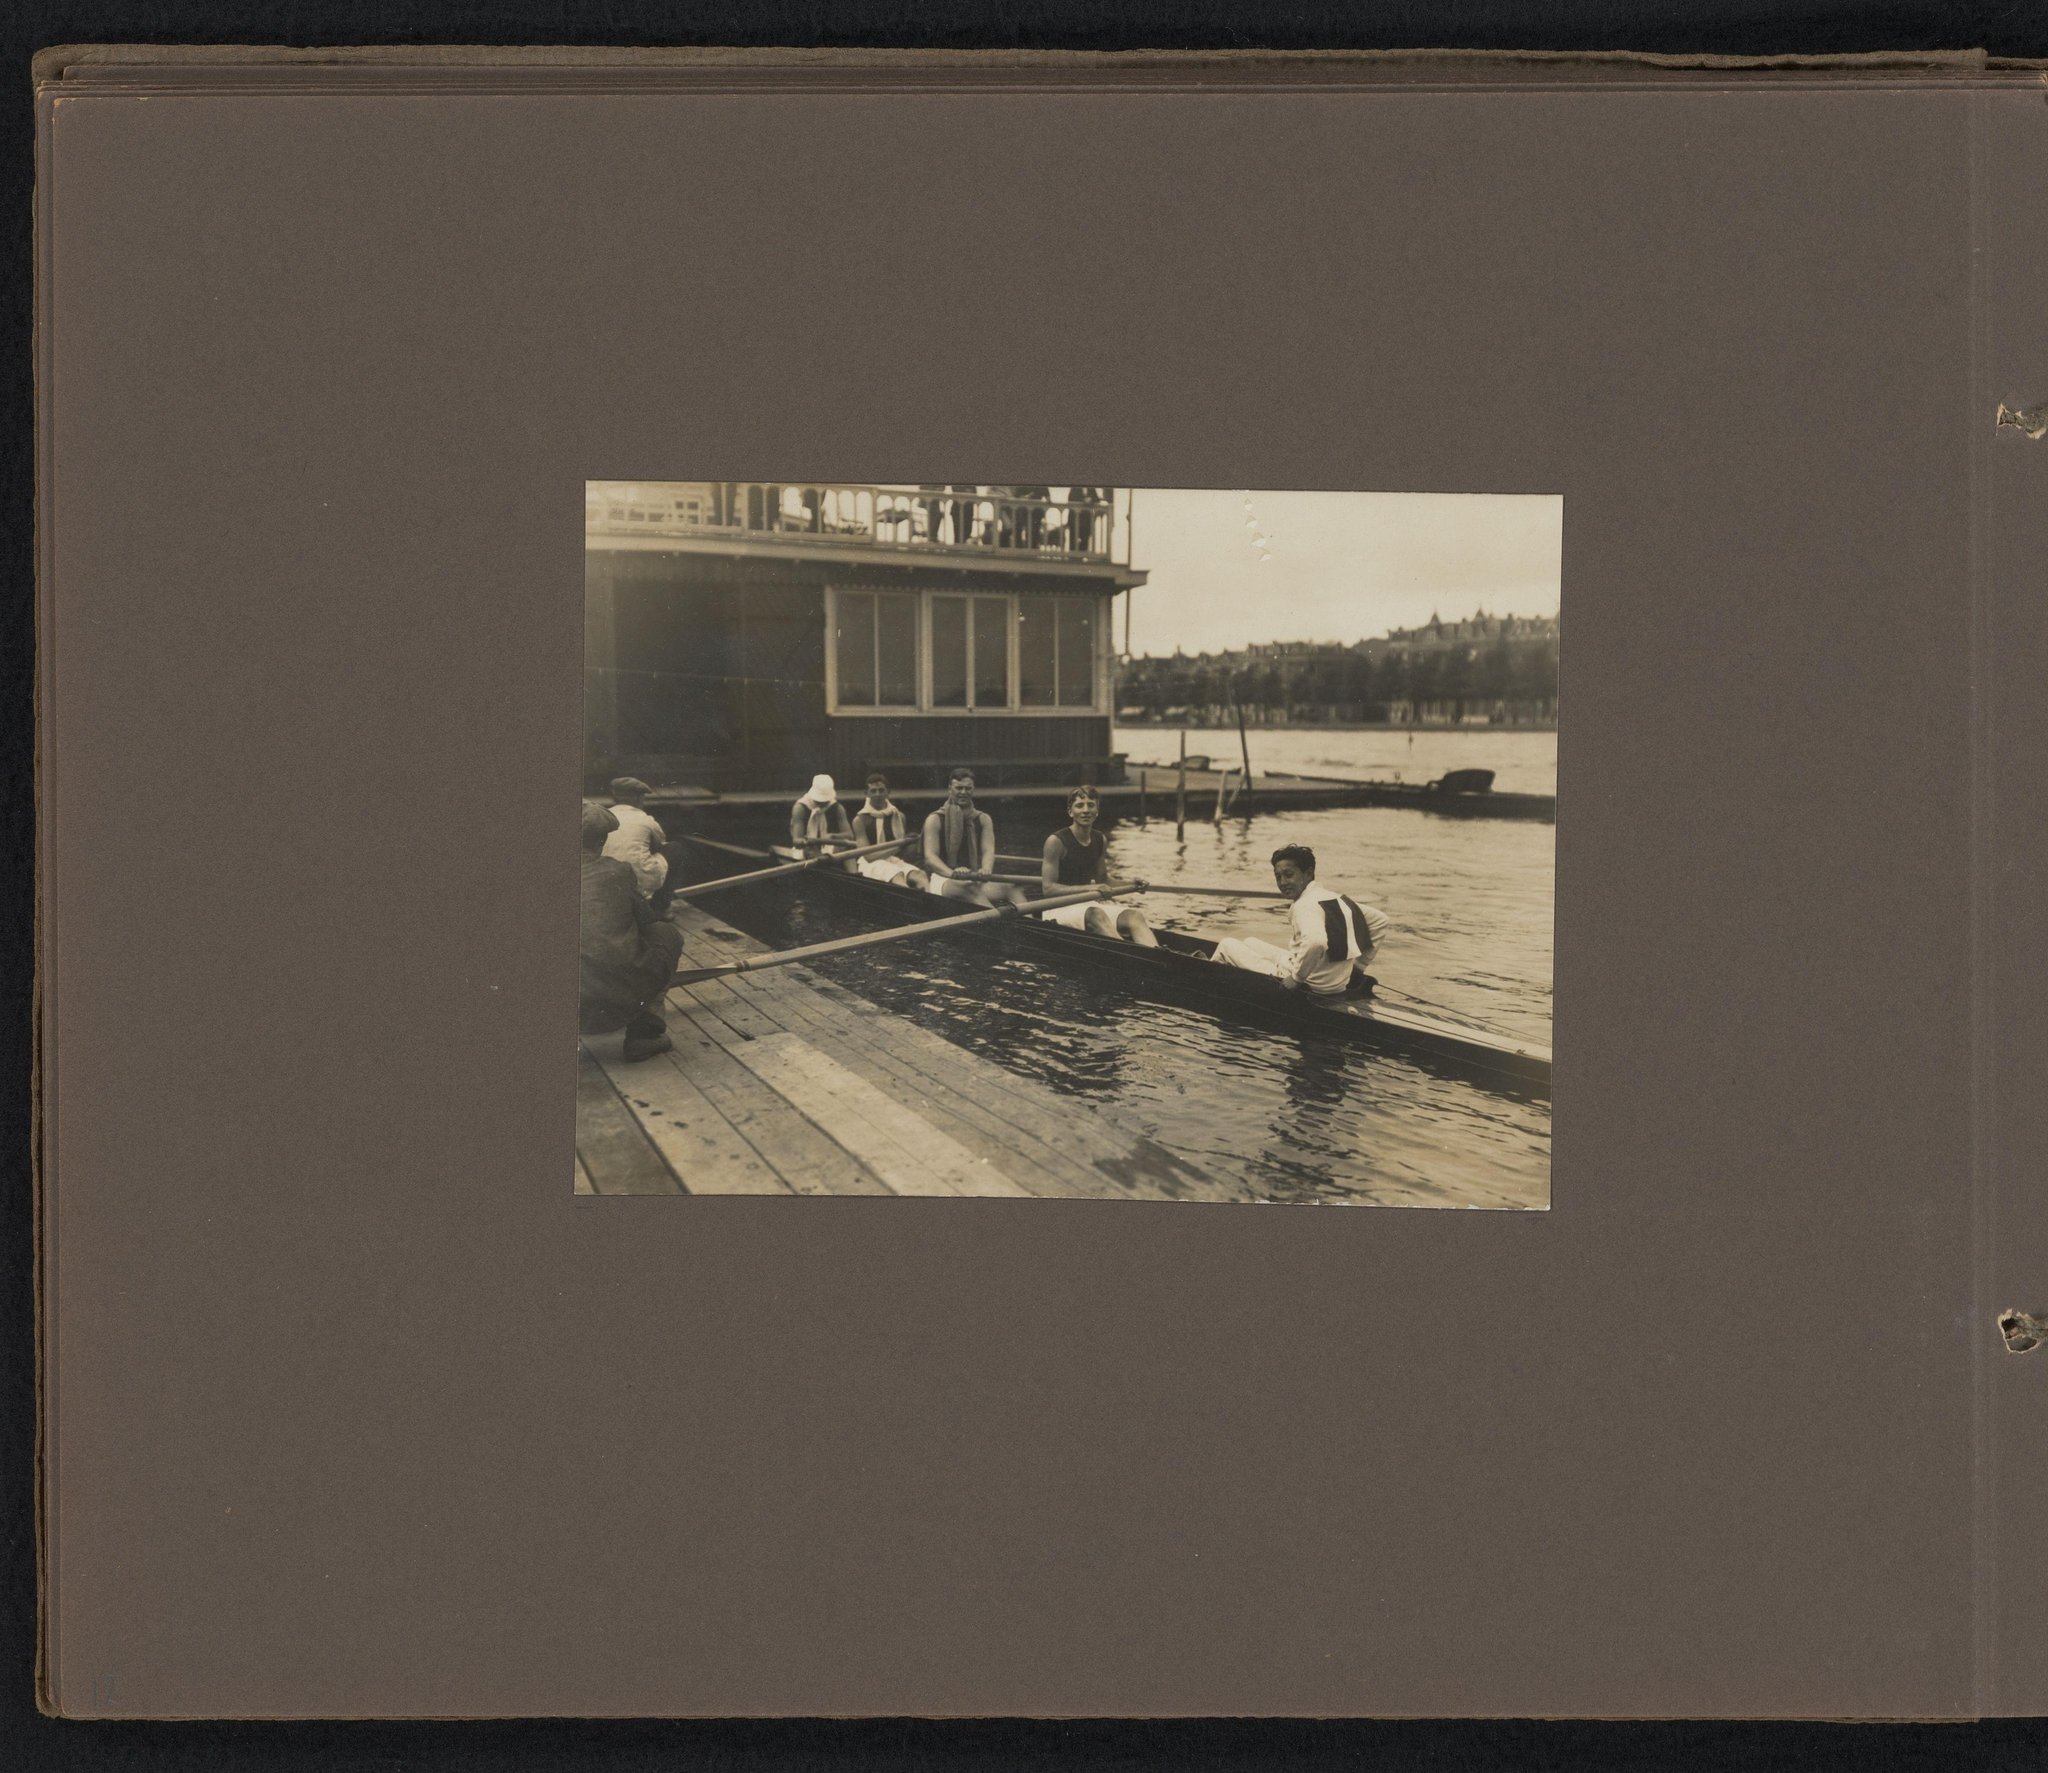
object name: album leaf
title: Roeiploeg Jonge Vier wordt van de kant geduwd met Nap Guldenaar als stuurman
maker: Anonymous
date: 1915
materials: paper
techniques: gelatin silver print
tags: rowing facing backward, pulling